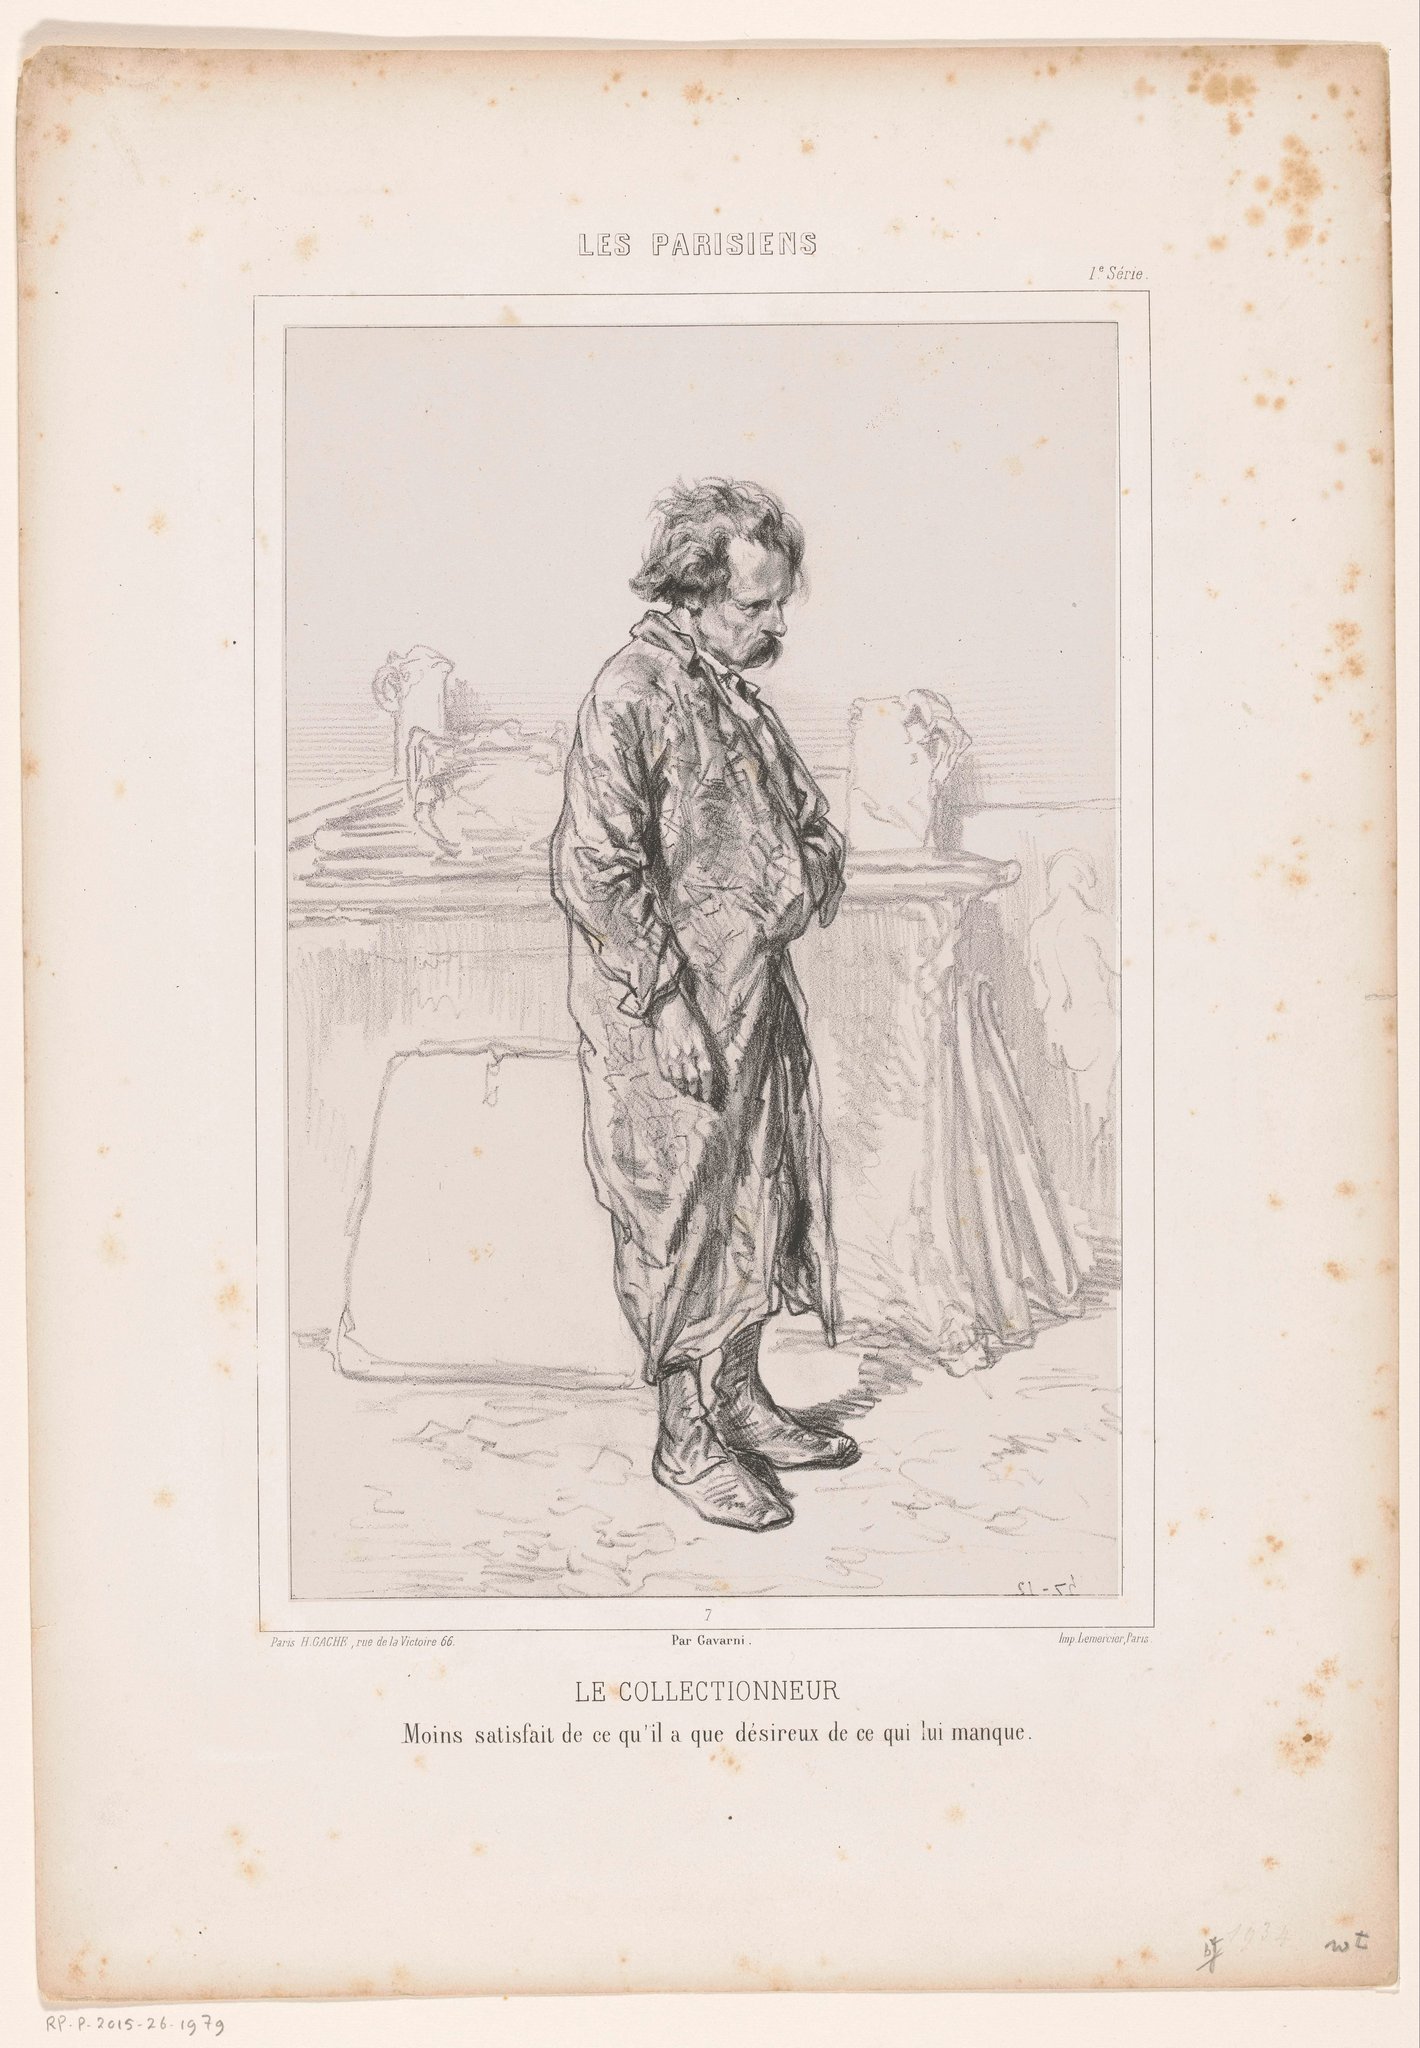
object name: print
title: Les Parisiens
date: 1857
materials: paper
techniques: lithograph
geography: paris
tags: art collector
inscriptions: collector's mark: Lugt 4779, collector's mark: Lugt 2228